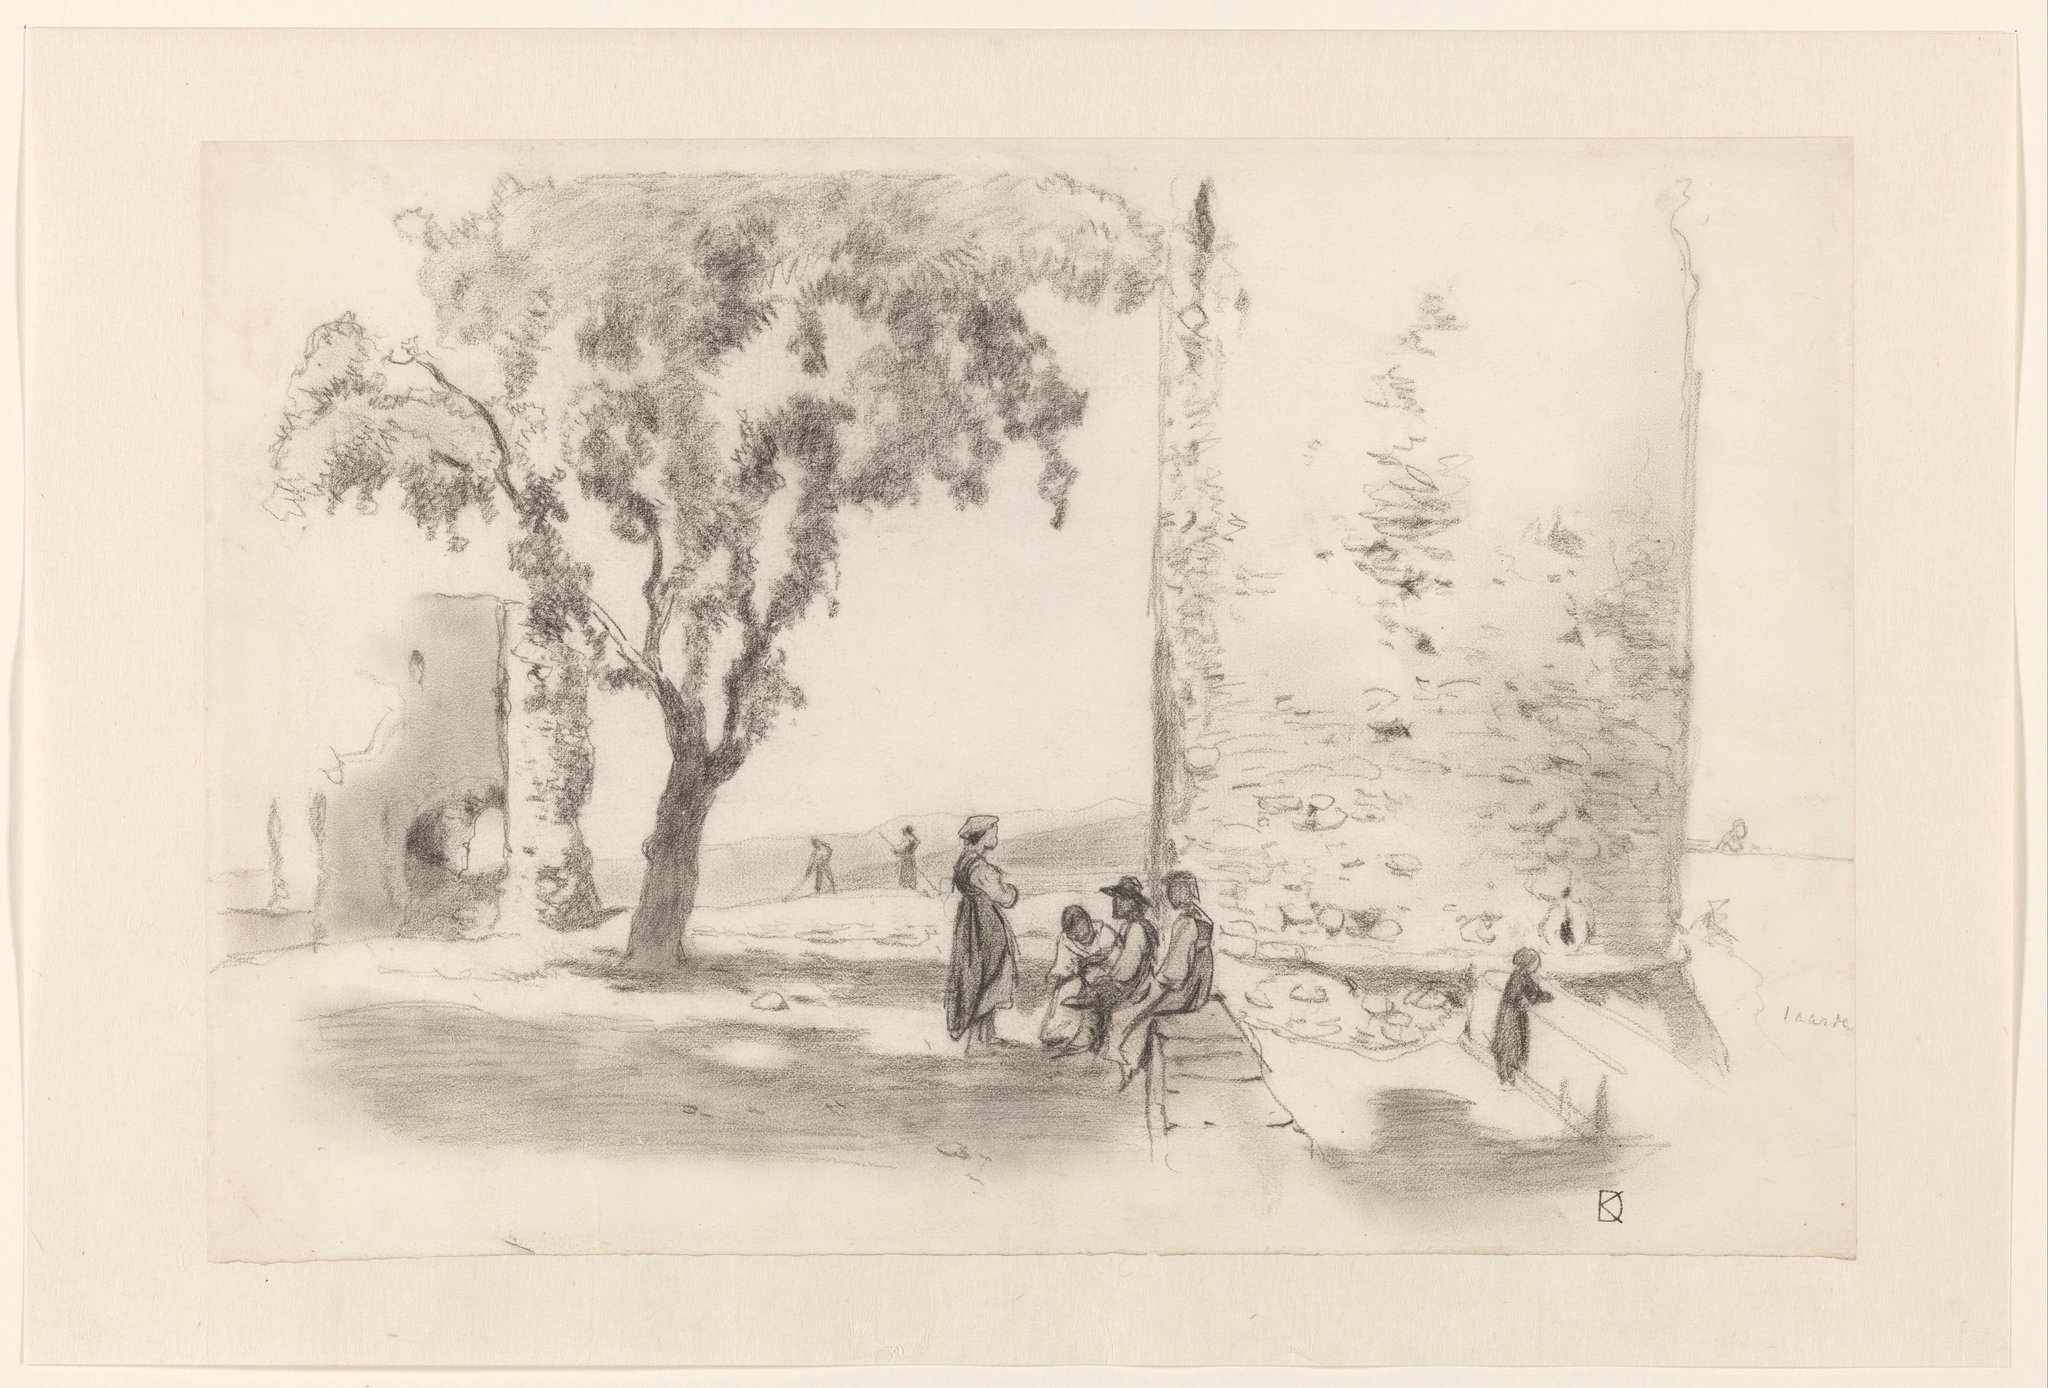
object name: drawing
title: Rustende landwerkers bij een toren onder een boom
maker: johan daniël koelman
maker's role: draughtsman, print maker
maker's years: 1831-1857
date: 1841-1857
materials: chalk, paper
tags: landscape with tower or castle, rest during harvest (eating, dancing, making love, etc.)